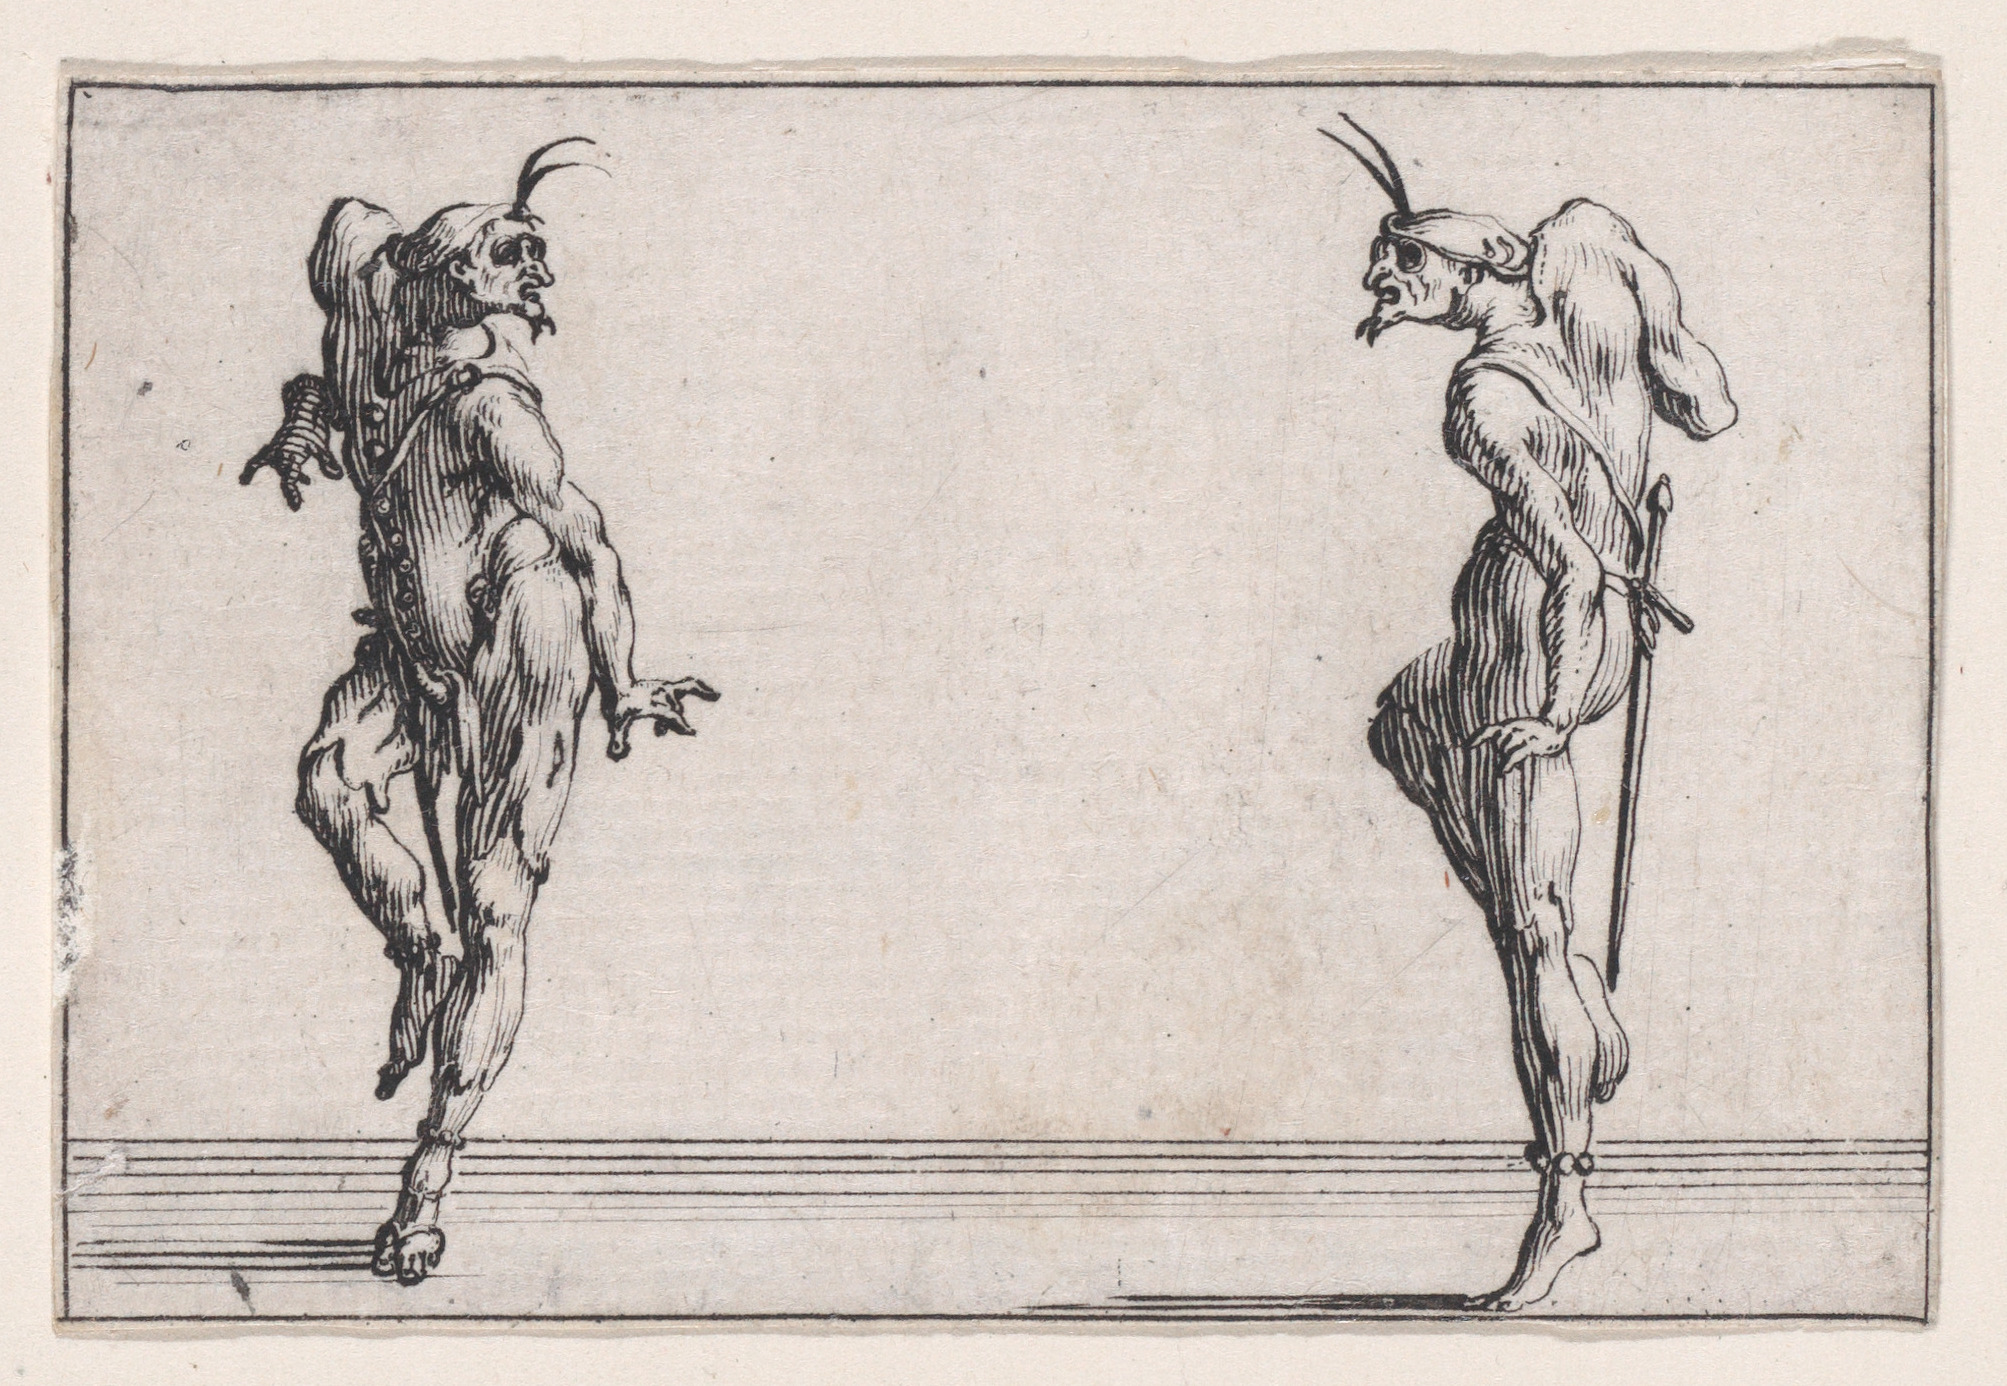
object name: print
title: Les Deux Pantalons se Regardant (Men in Pantsuits Looking at Each Other), from "Les Caprices" Series A, The Florence Set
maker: jacques callot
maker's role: artist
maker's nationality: french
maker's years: 1592-1635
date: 1617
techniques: etching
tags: men